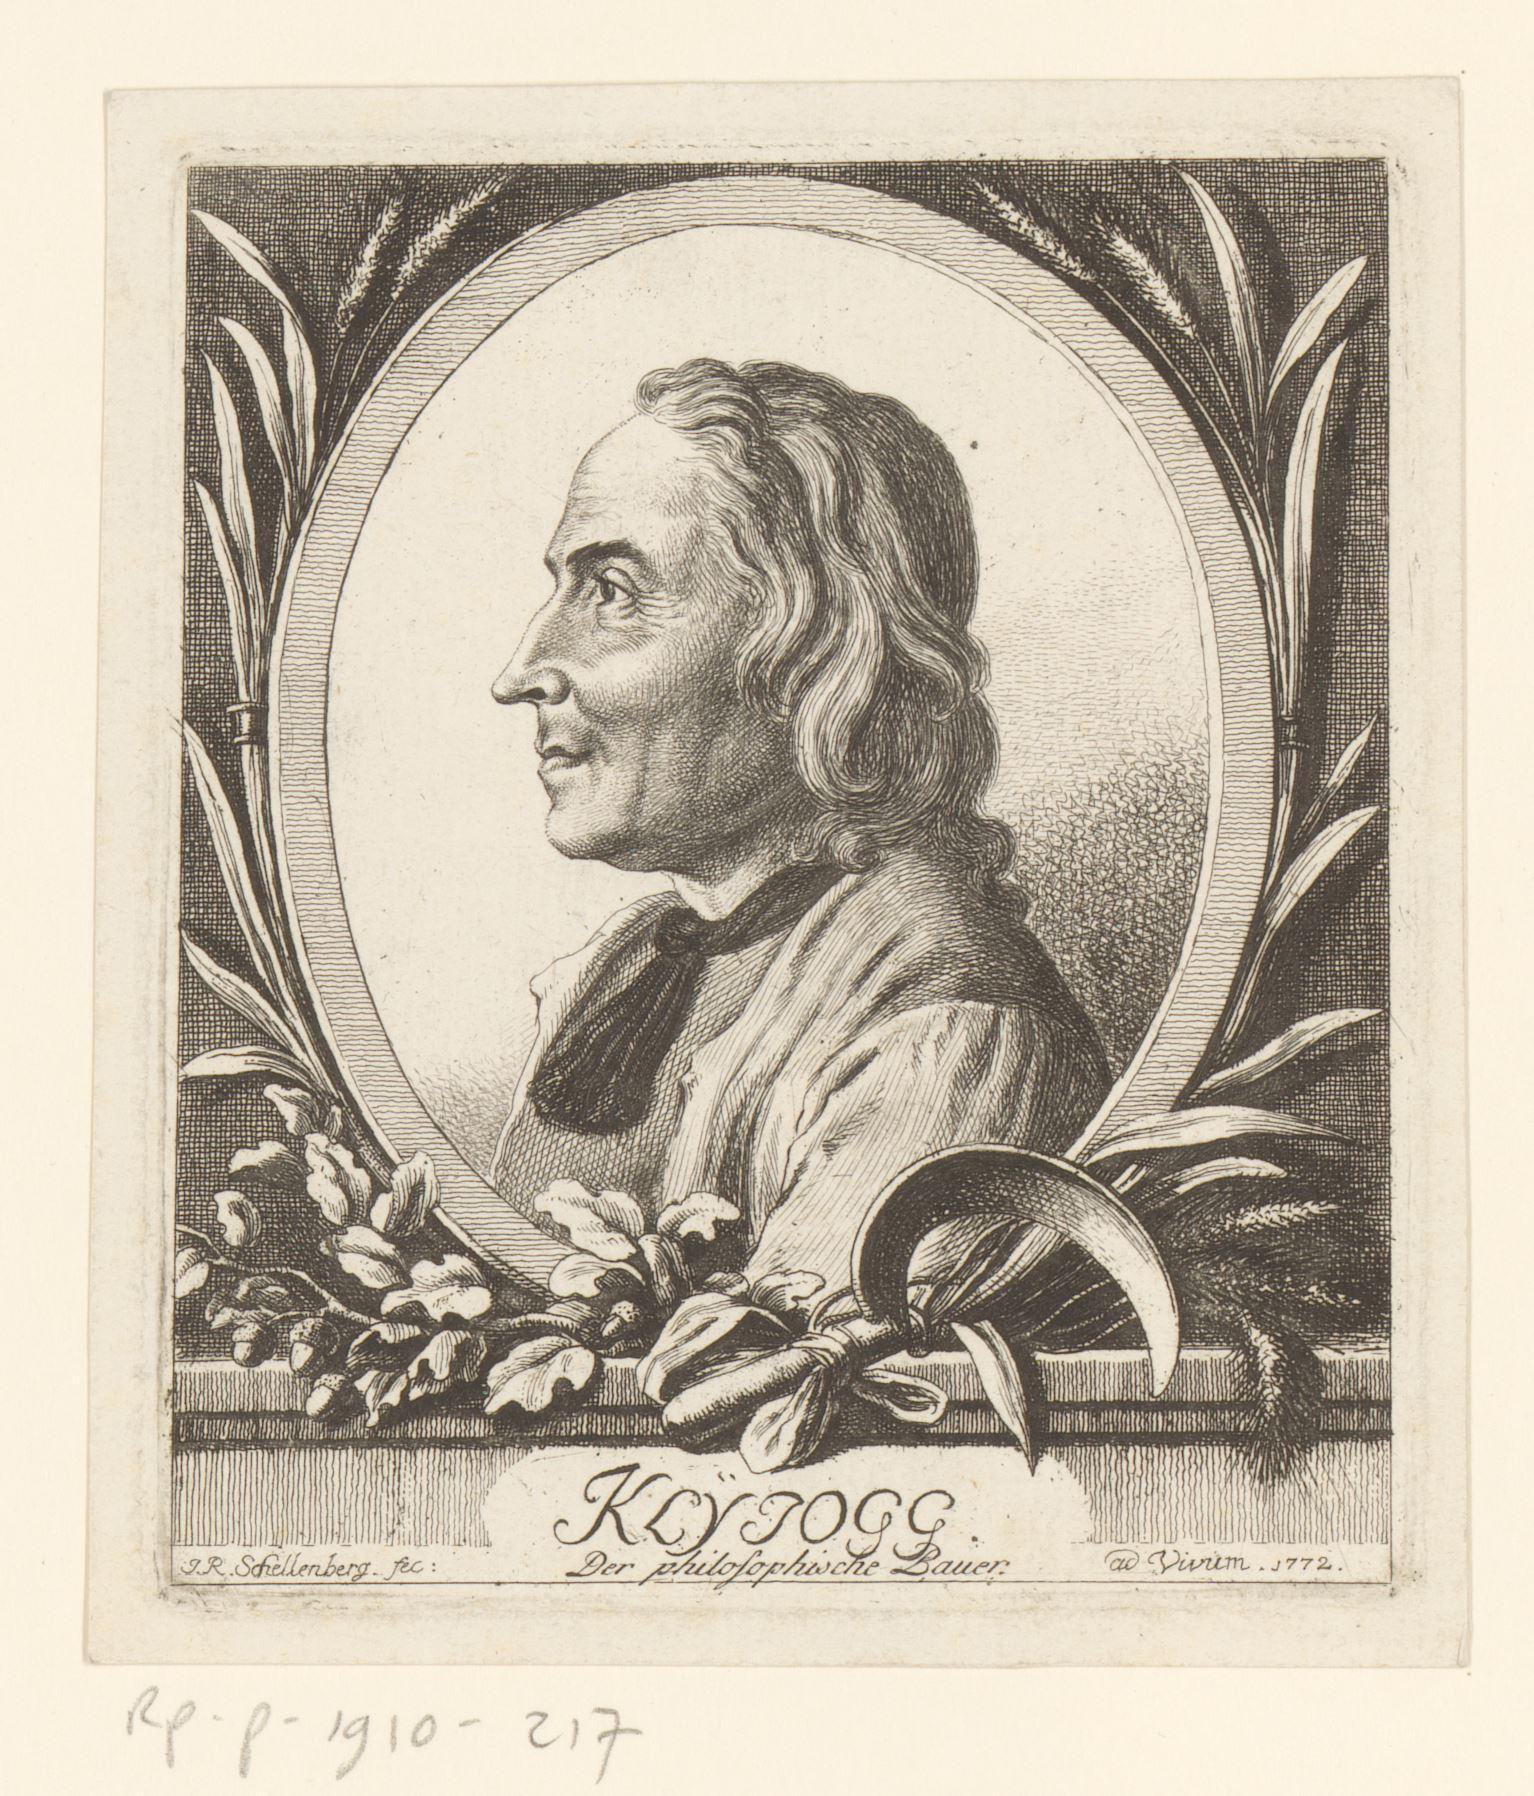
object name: print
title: Portret van Kleinjogg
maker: johann rudolph schellenberg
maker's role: print maker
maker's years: 1740-1806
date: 1772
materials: paper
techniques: etching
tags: switzerland, scholar, philosopher, historical persons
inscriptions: collector's mark: Lugt 2228